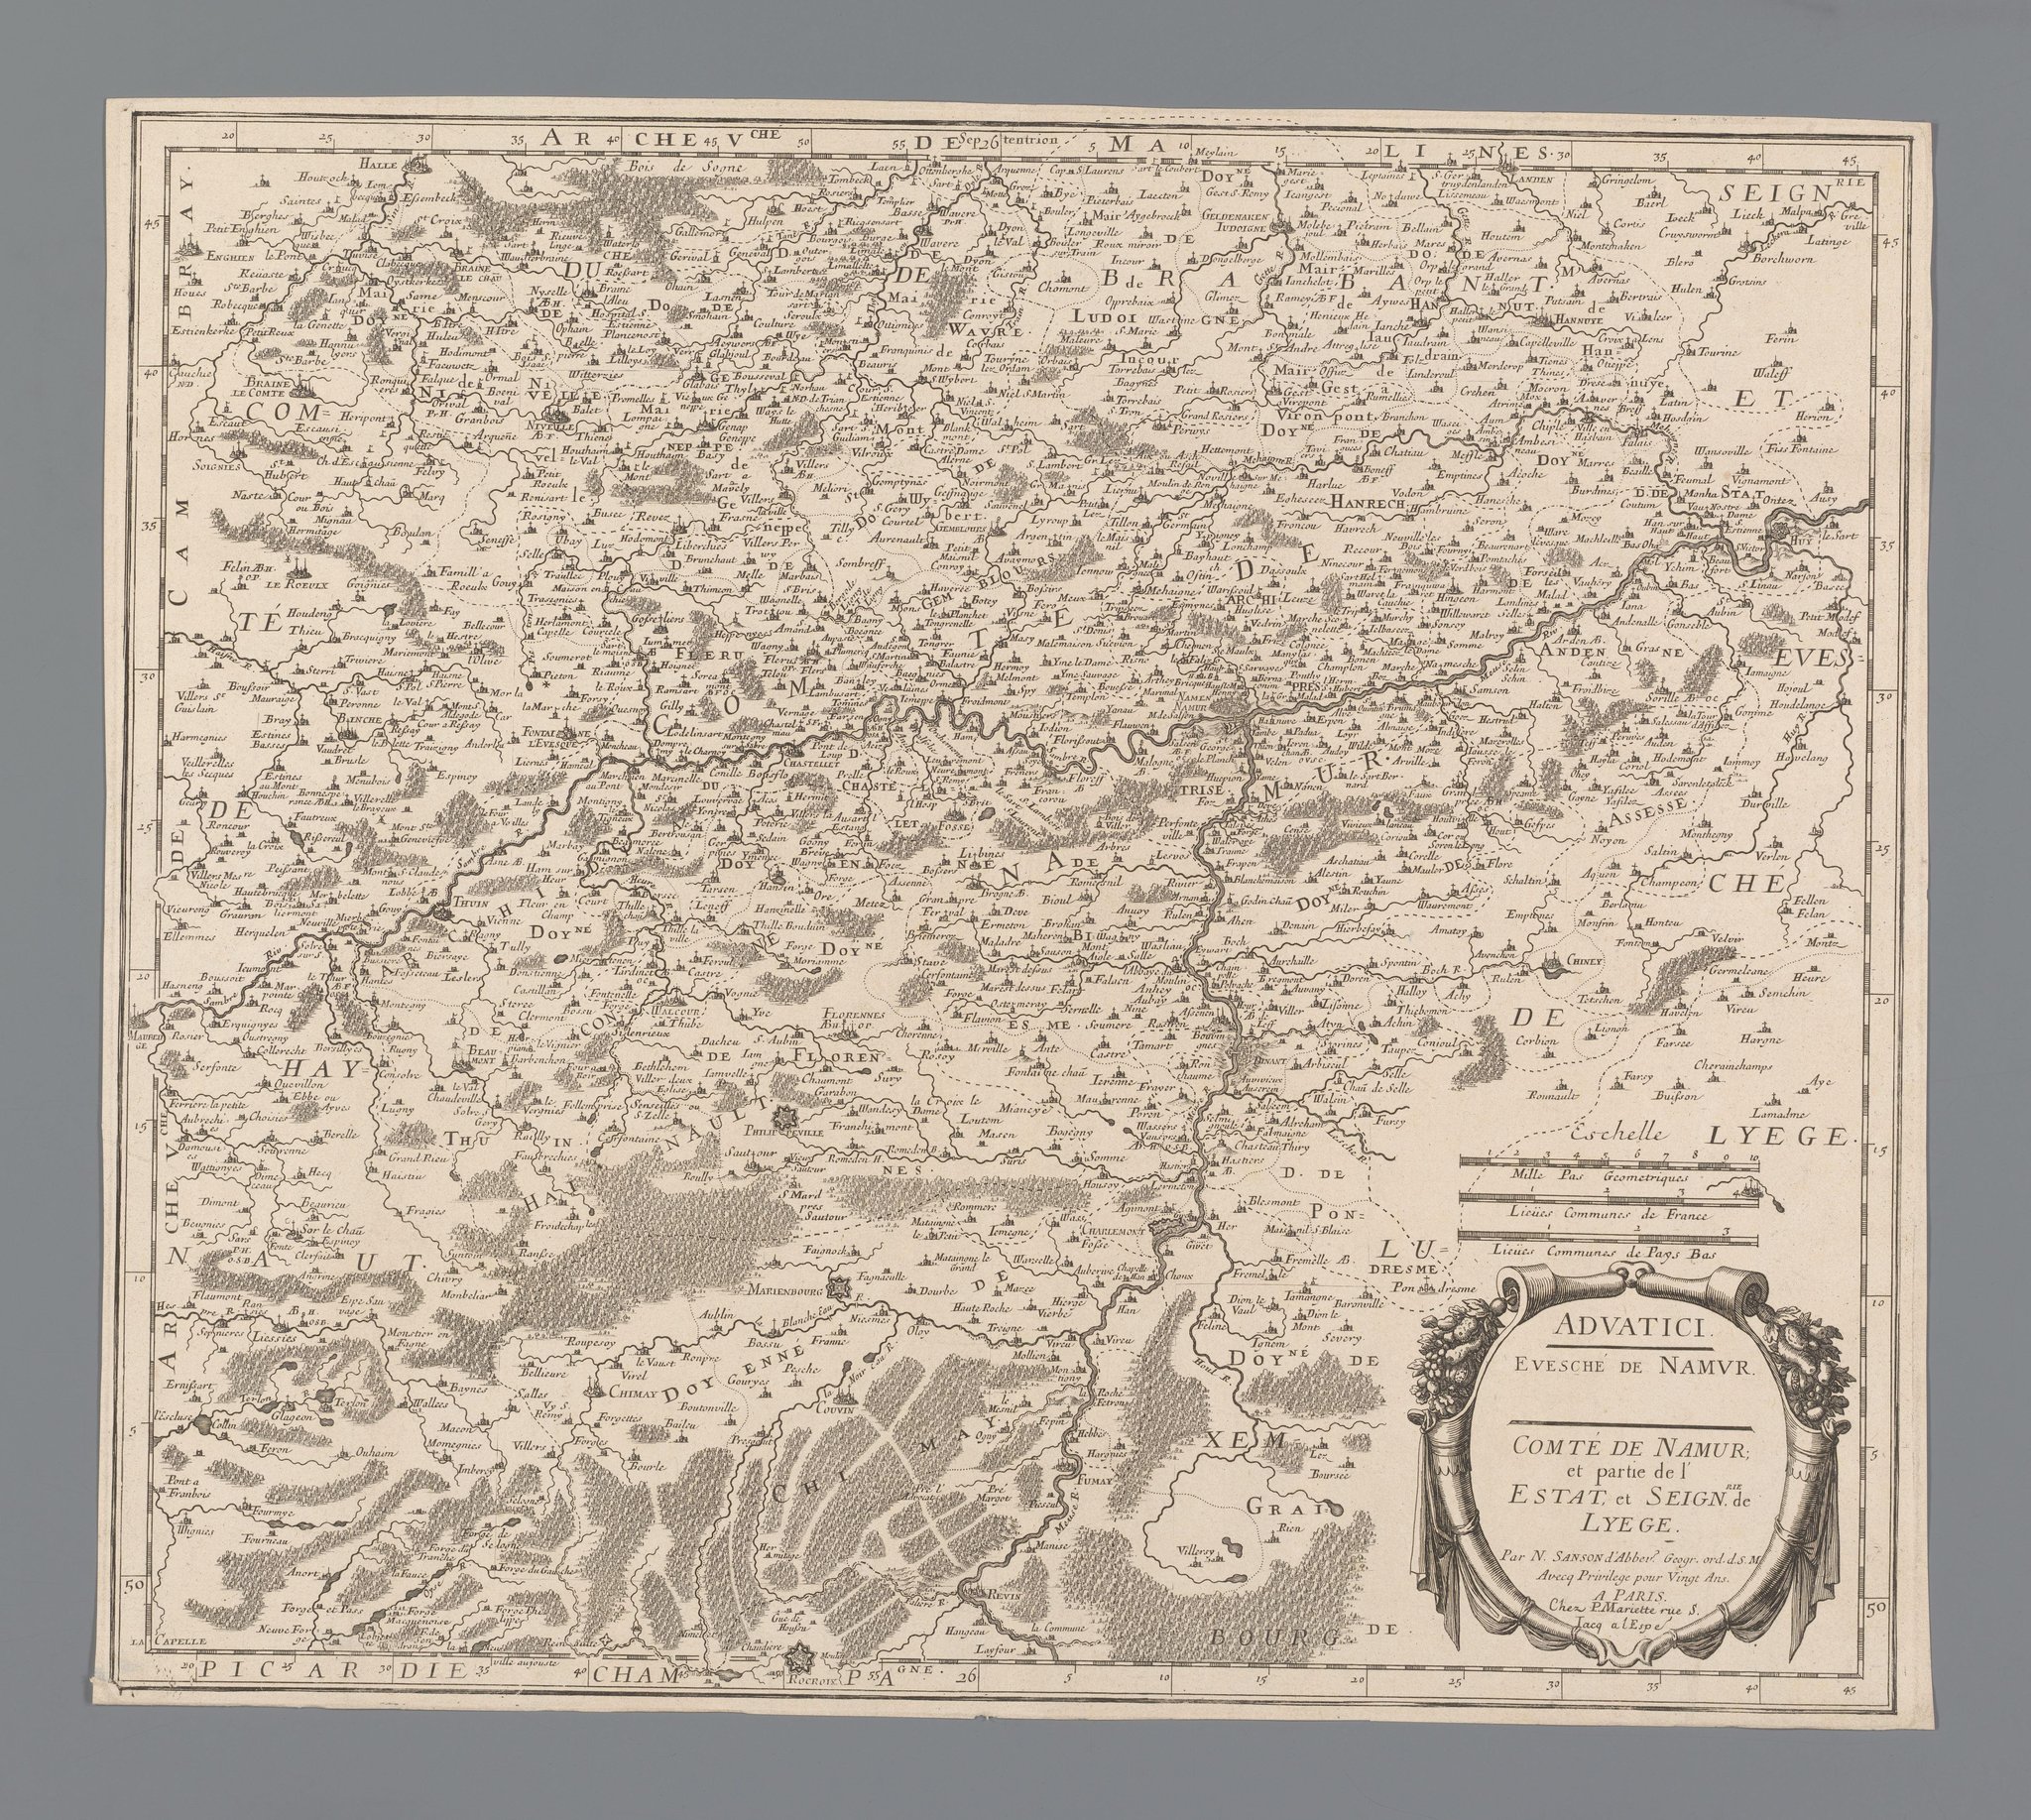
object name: map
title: Kaart van het graafschap Namen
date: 1647-1667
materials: paper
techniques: etching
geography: paris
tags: maps of separate countries or regions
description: Kaart van het graafschap Namen. Rechtsonder de titelcartouche. Daarboven drie schaalstokken: 10 Mille Pas Geometriques / 4 Lieües Communes de France / 3 Lieües Communes de Pays Bas. De kaart is voorzien van een gradenverdeling langs de randen.